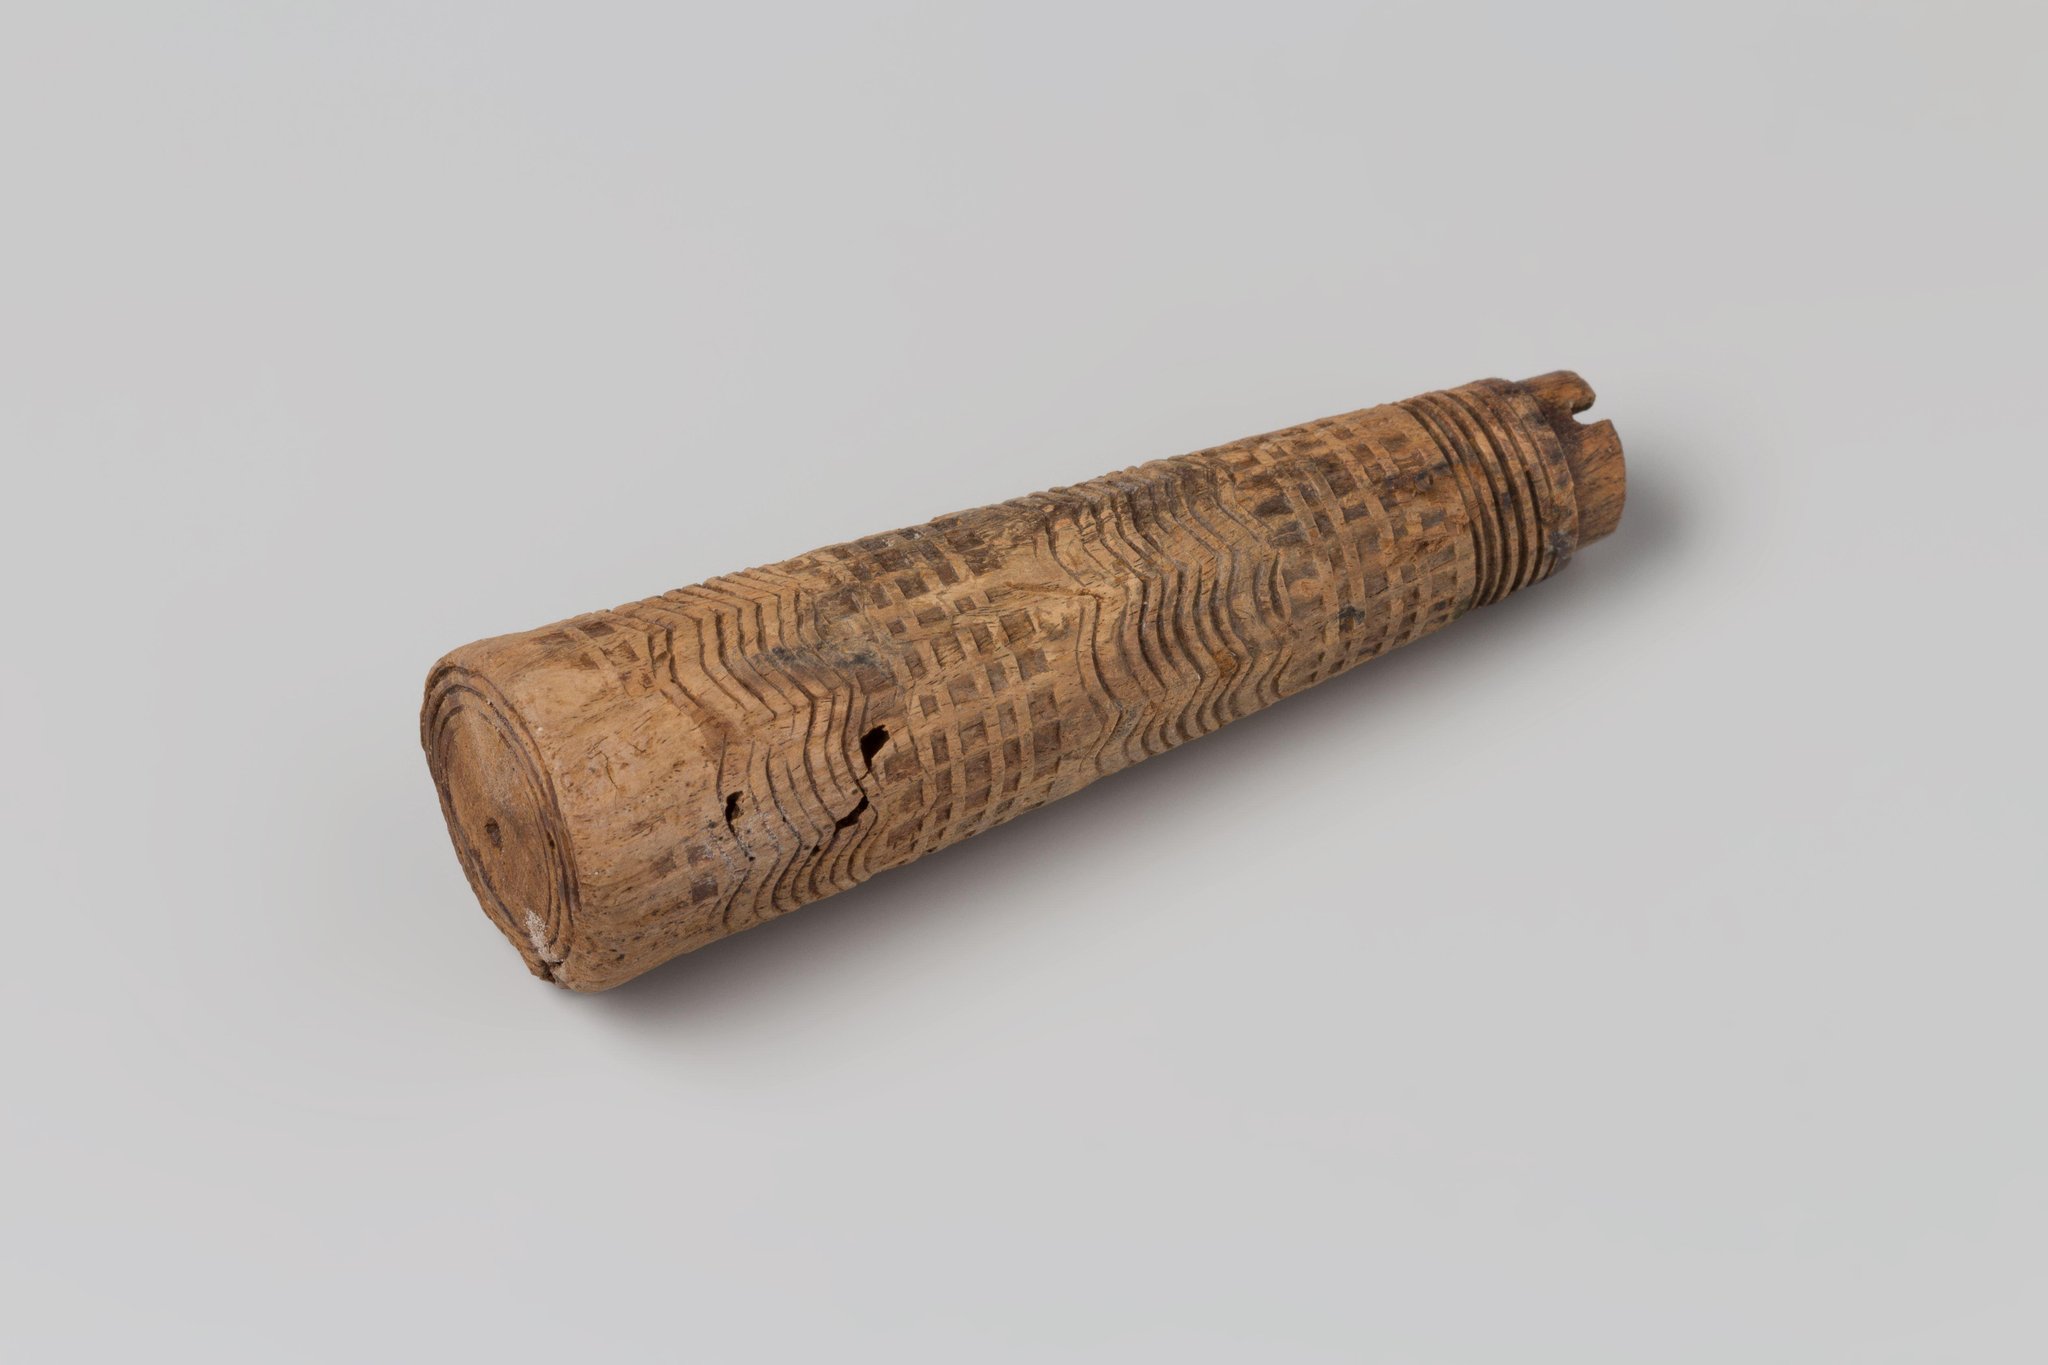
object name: knife handle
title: Messenheft uit het wrak van de Oost-Indiëvaarder Hollandia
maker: Anonymous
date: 1700-1743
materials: wood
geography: netherlands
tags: verenigde oostindische compagnie, hollandia (schip), annet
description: Knife, handle, cylindrical: tapering; id. NG 1979-403H.